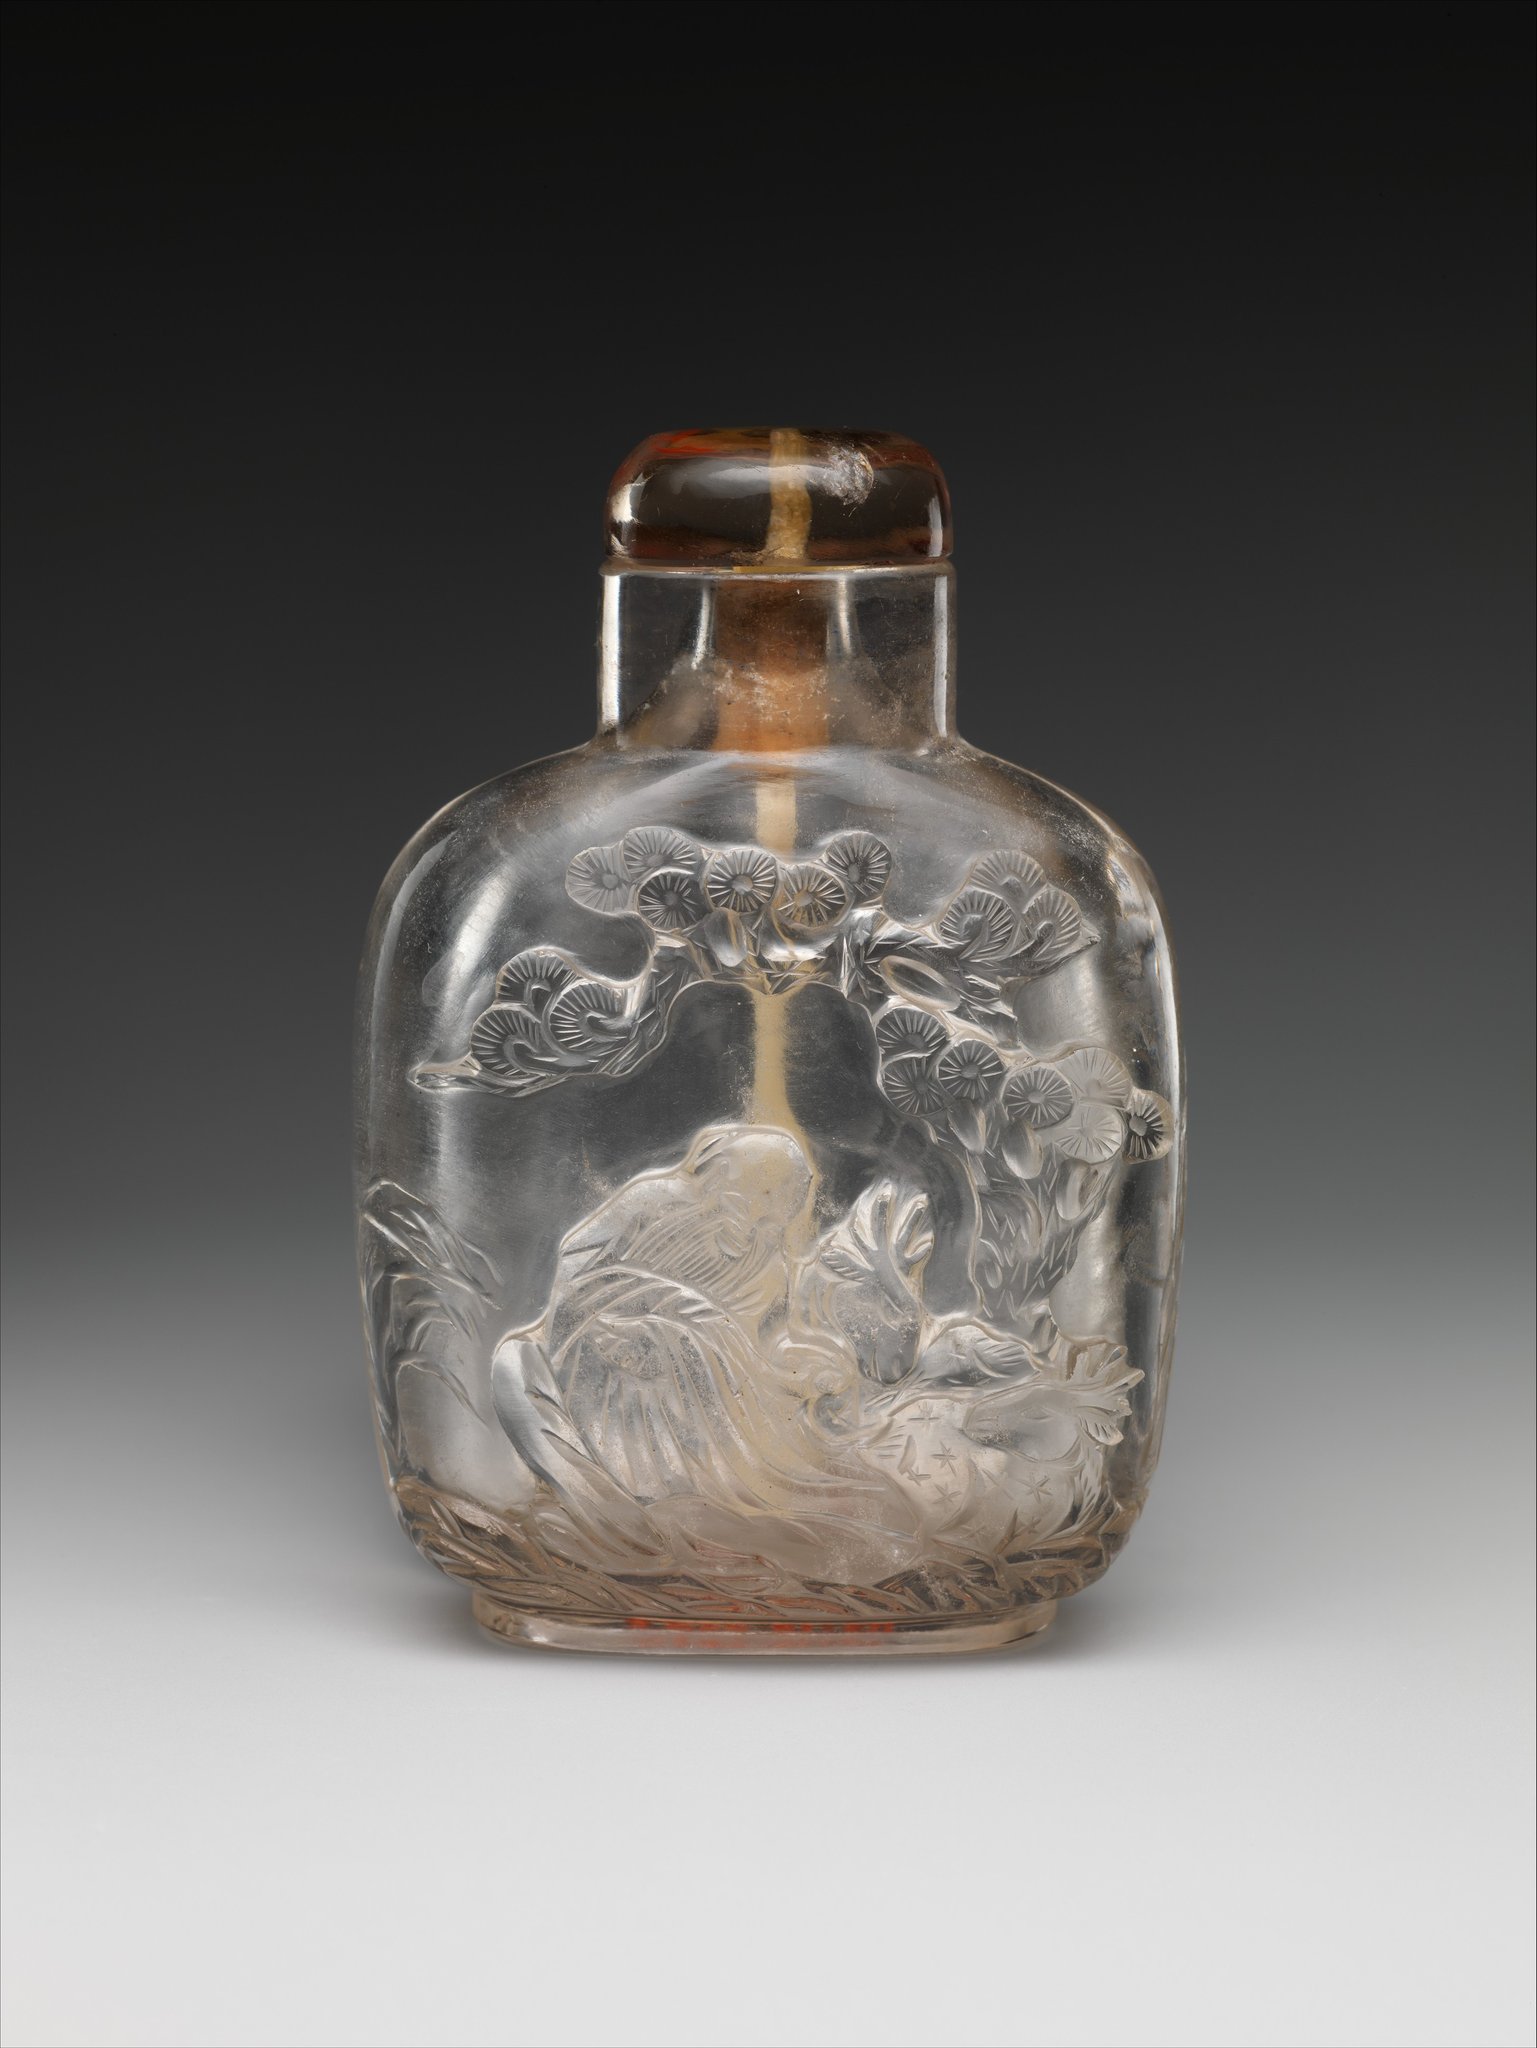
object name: snuff bottle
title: Snuff bottle with god of longevity and deer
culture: chinese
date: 1701-1900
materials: quartz, gemstone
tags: men,deer